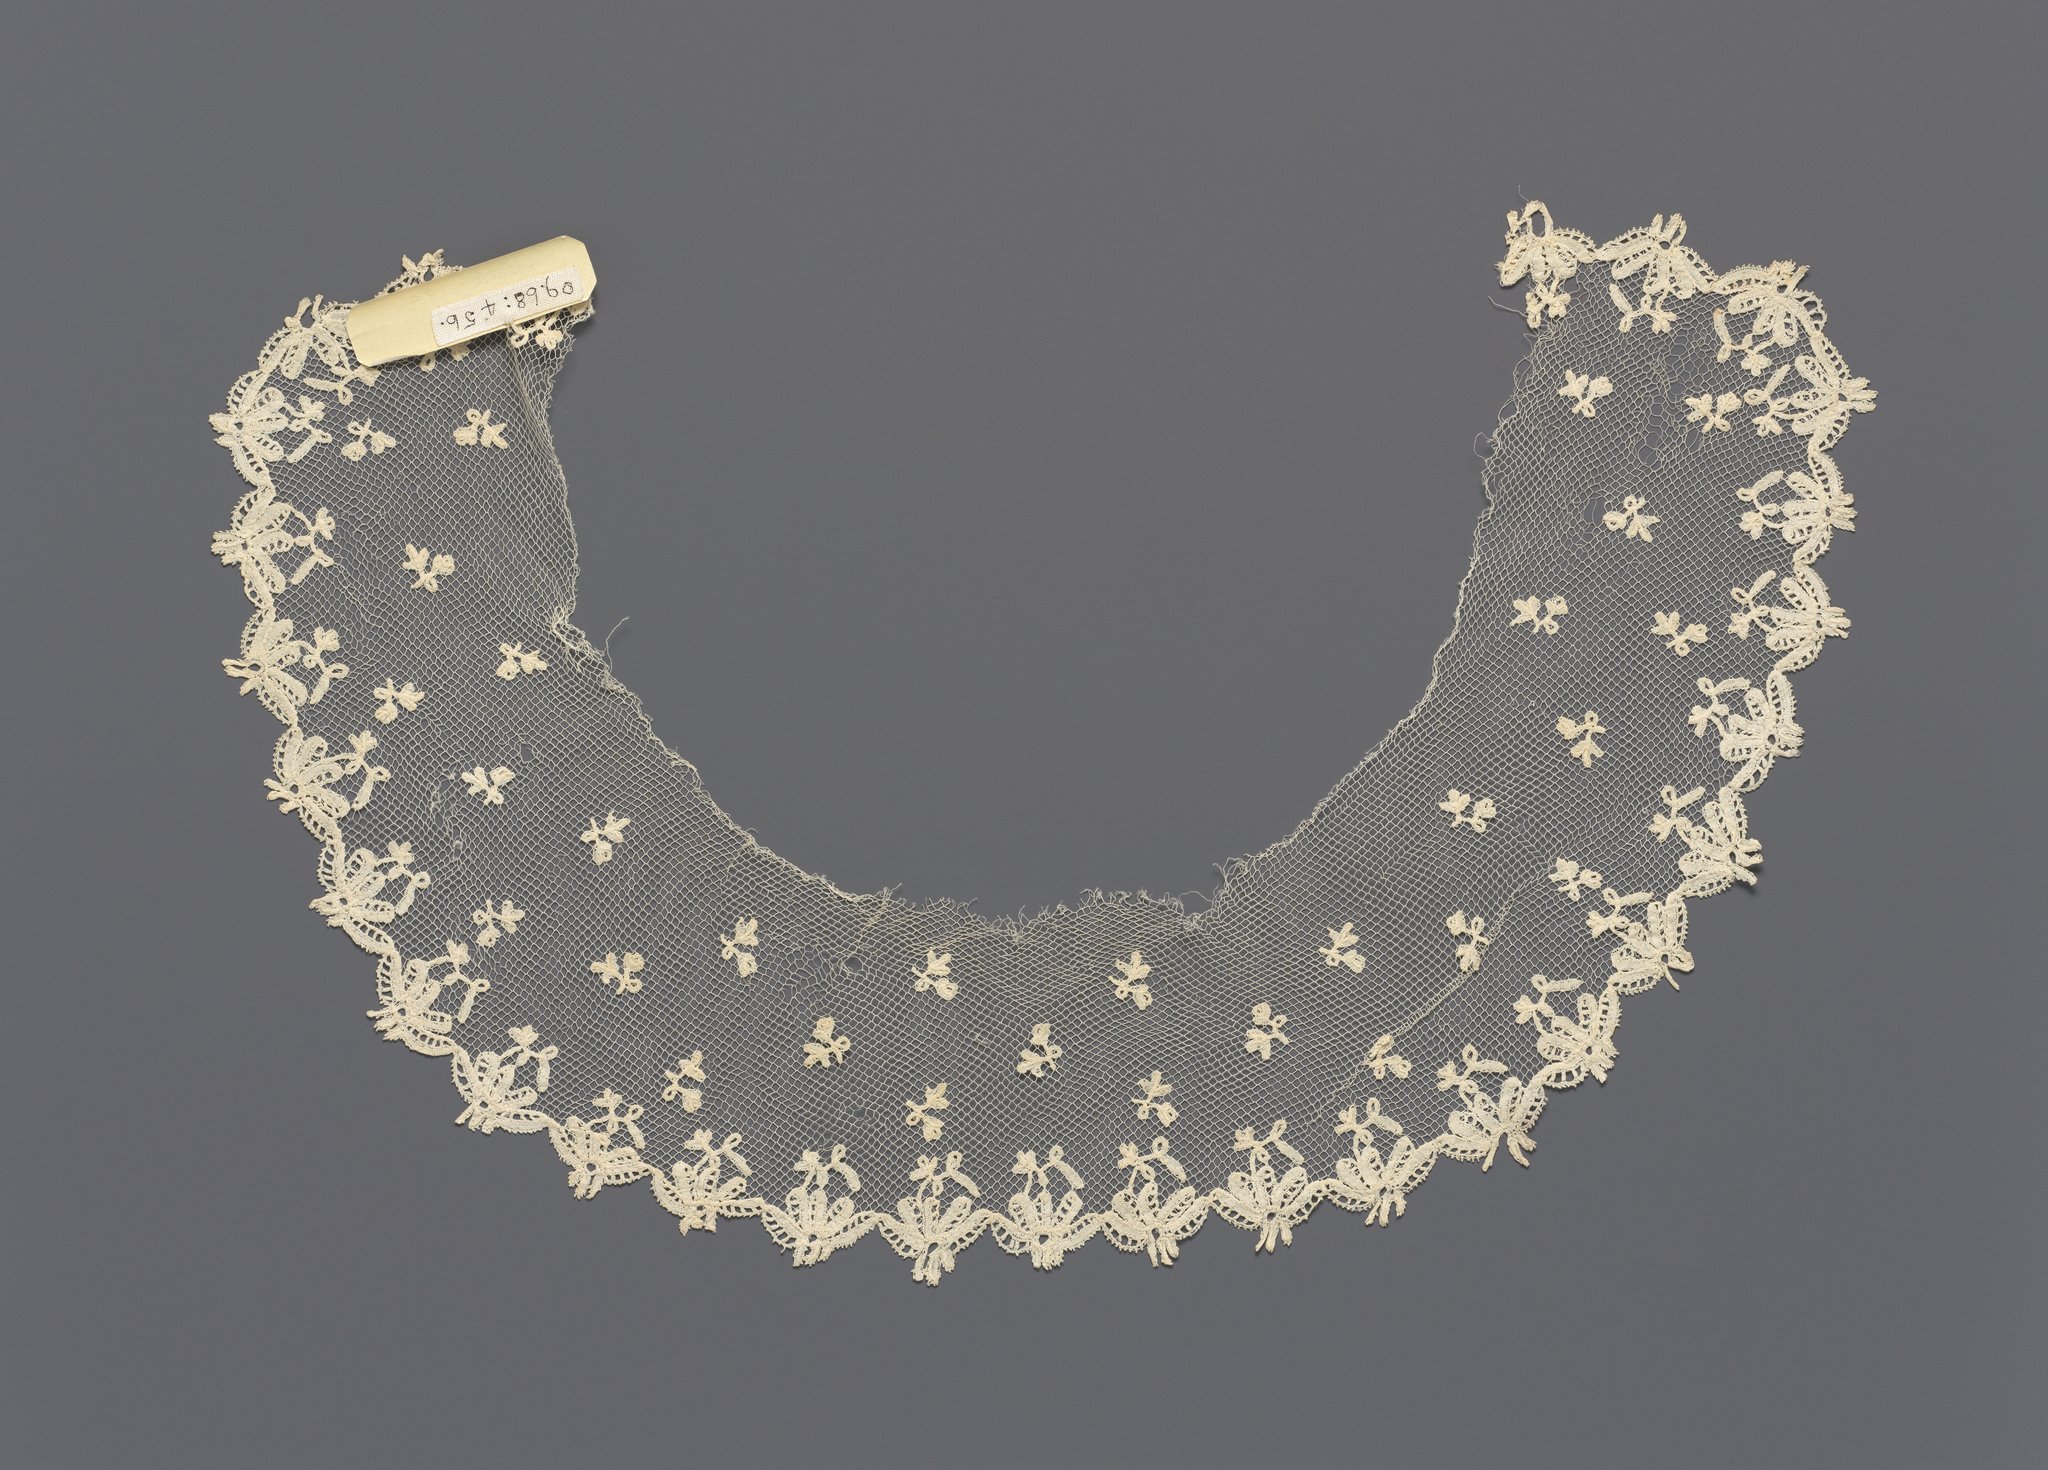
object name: collar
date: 1801-1900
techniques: lace